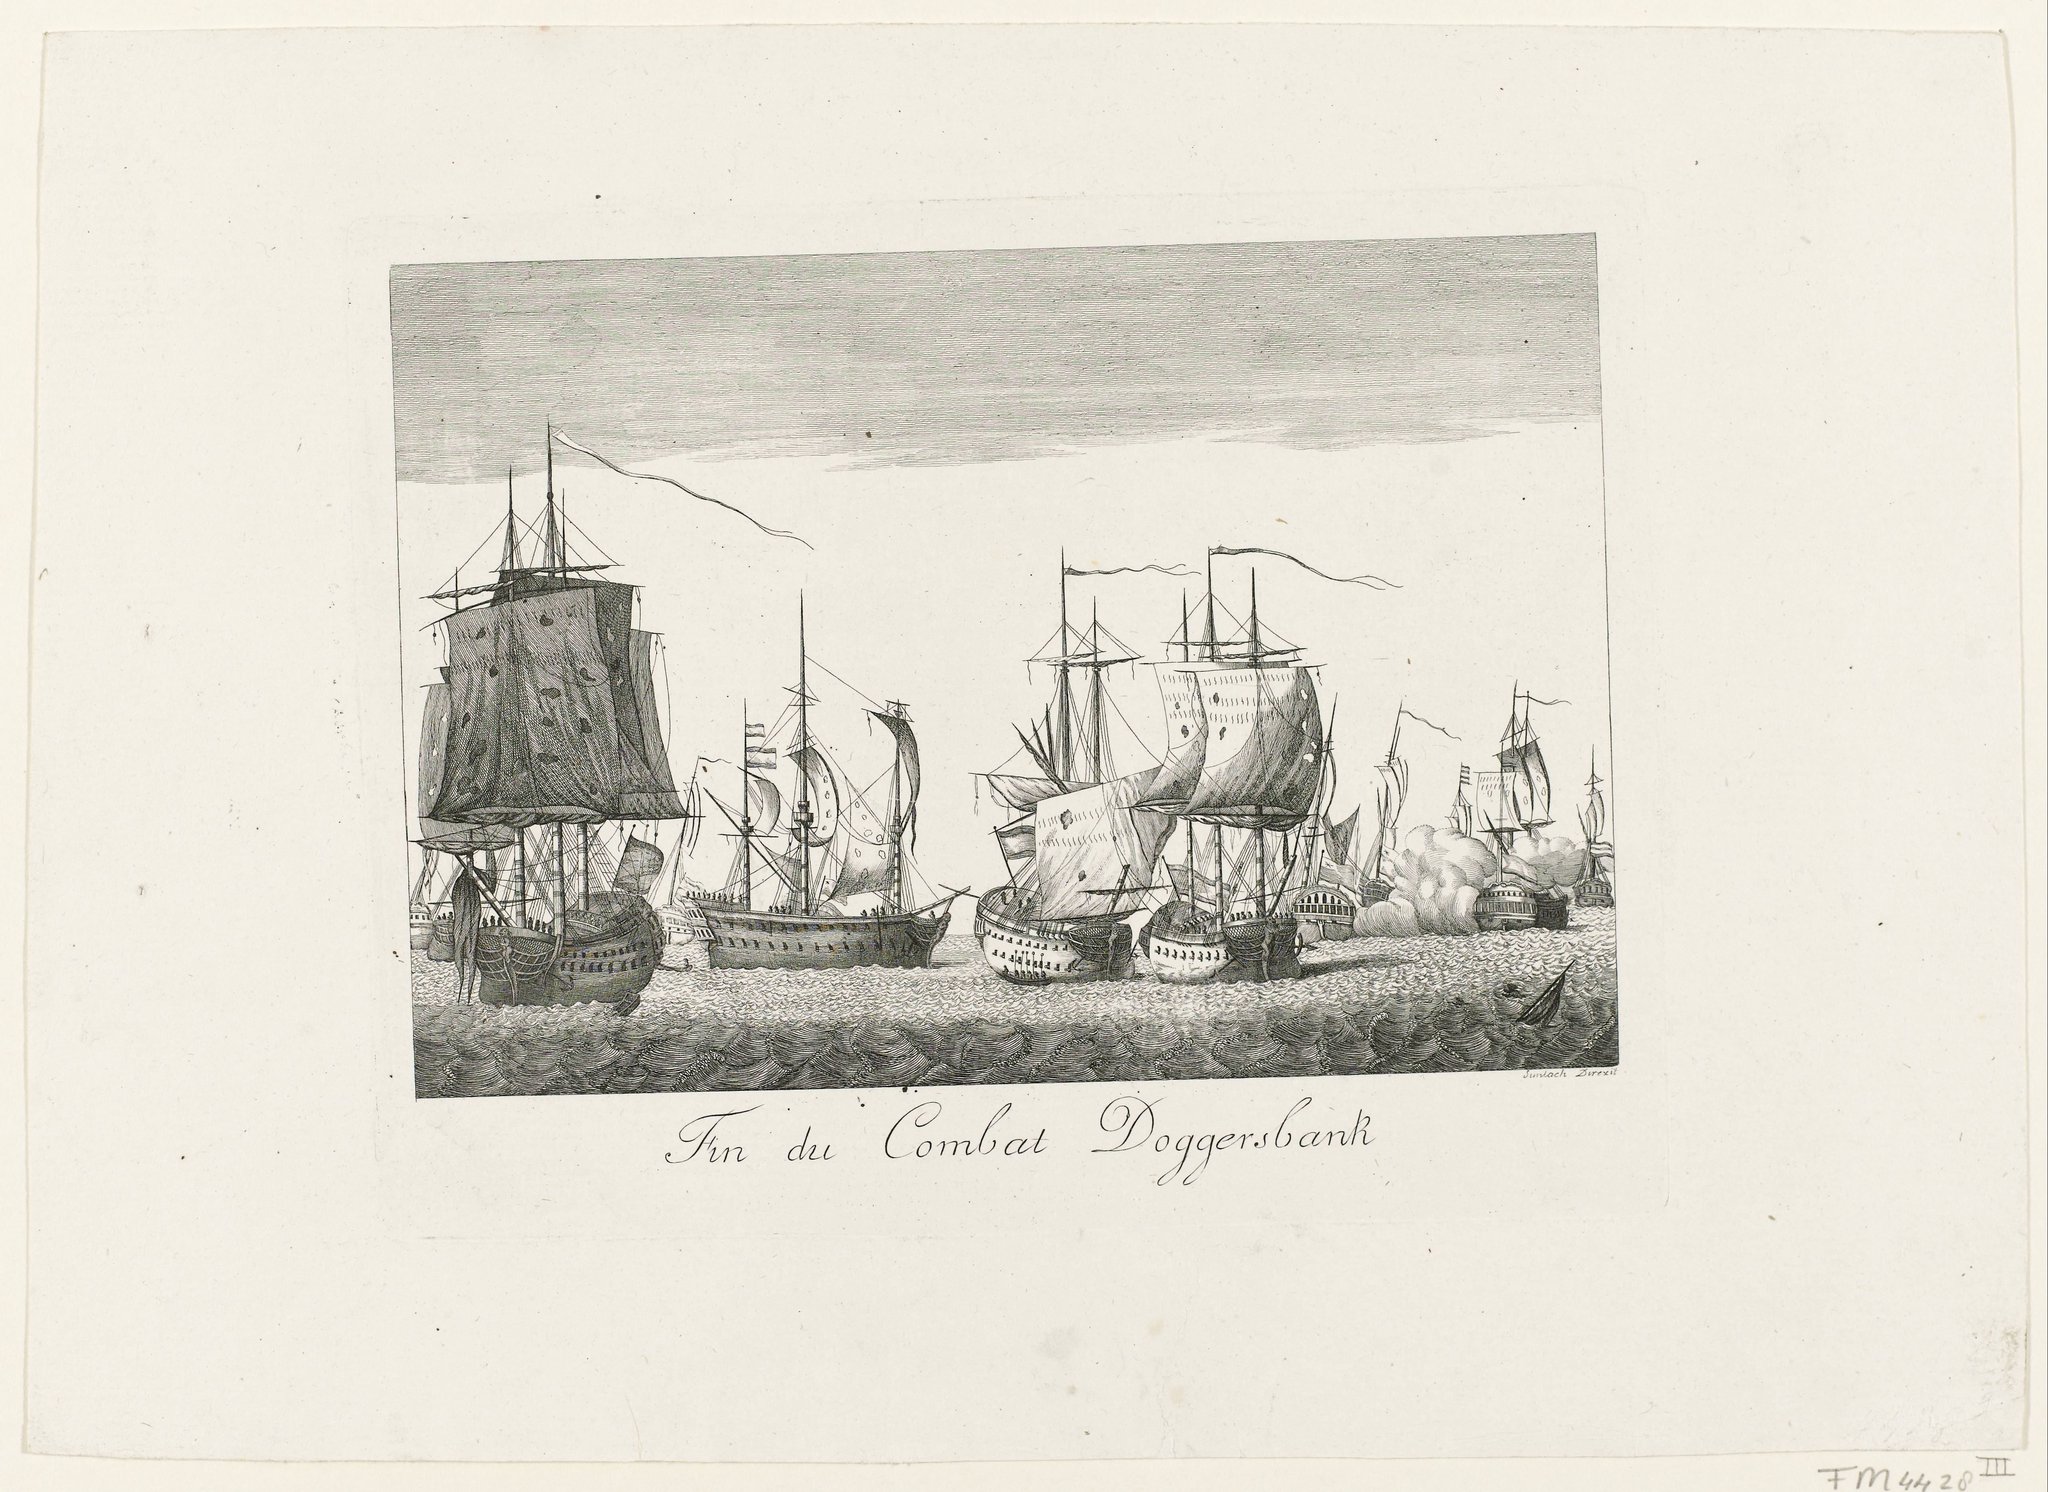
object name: print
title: Einde van de zeeslag bij Doggersbank, 1781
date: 1782-1790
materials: paper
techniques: engraving, etching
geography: rotterdam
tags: johan arnold zoutman, hyde parker, battle (+ naval force)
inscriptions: collector's mark: Lugt 2228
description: Het einde van de zeeslag bij Doggersbank op 5 augustus 1781 tussen de Nederlandse vloot onder schout-bij-nacht Johan Zoutman en de Engelse vloot onder vice-admiraal Hyde Parker. In de marge de titel in het Frans. Onderdeel van een serie van vier platen van zeeslagen in het jaar 1781.